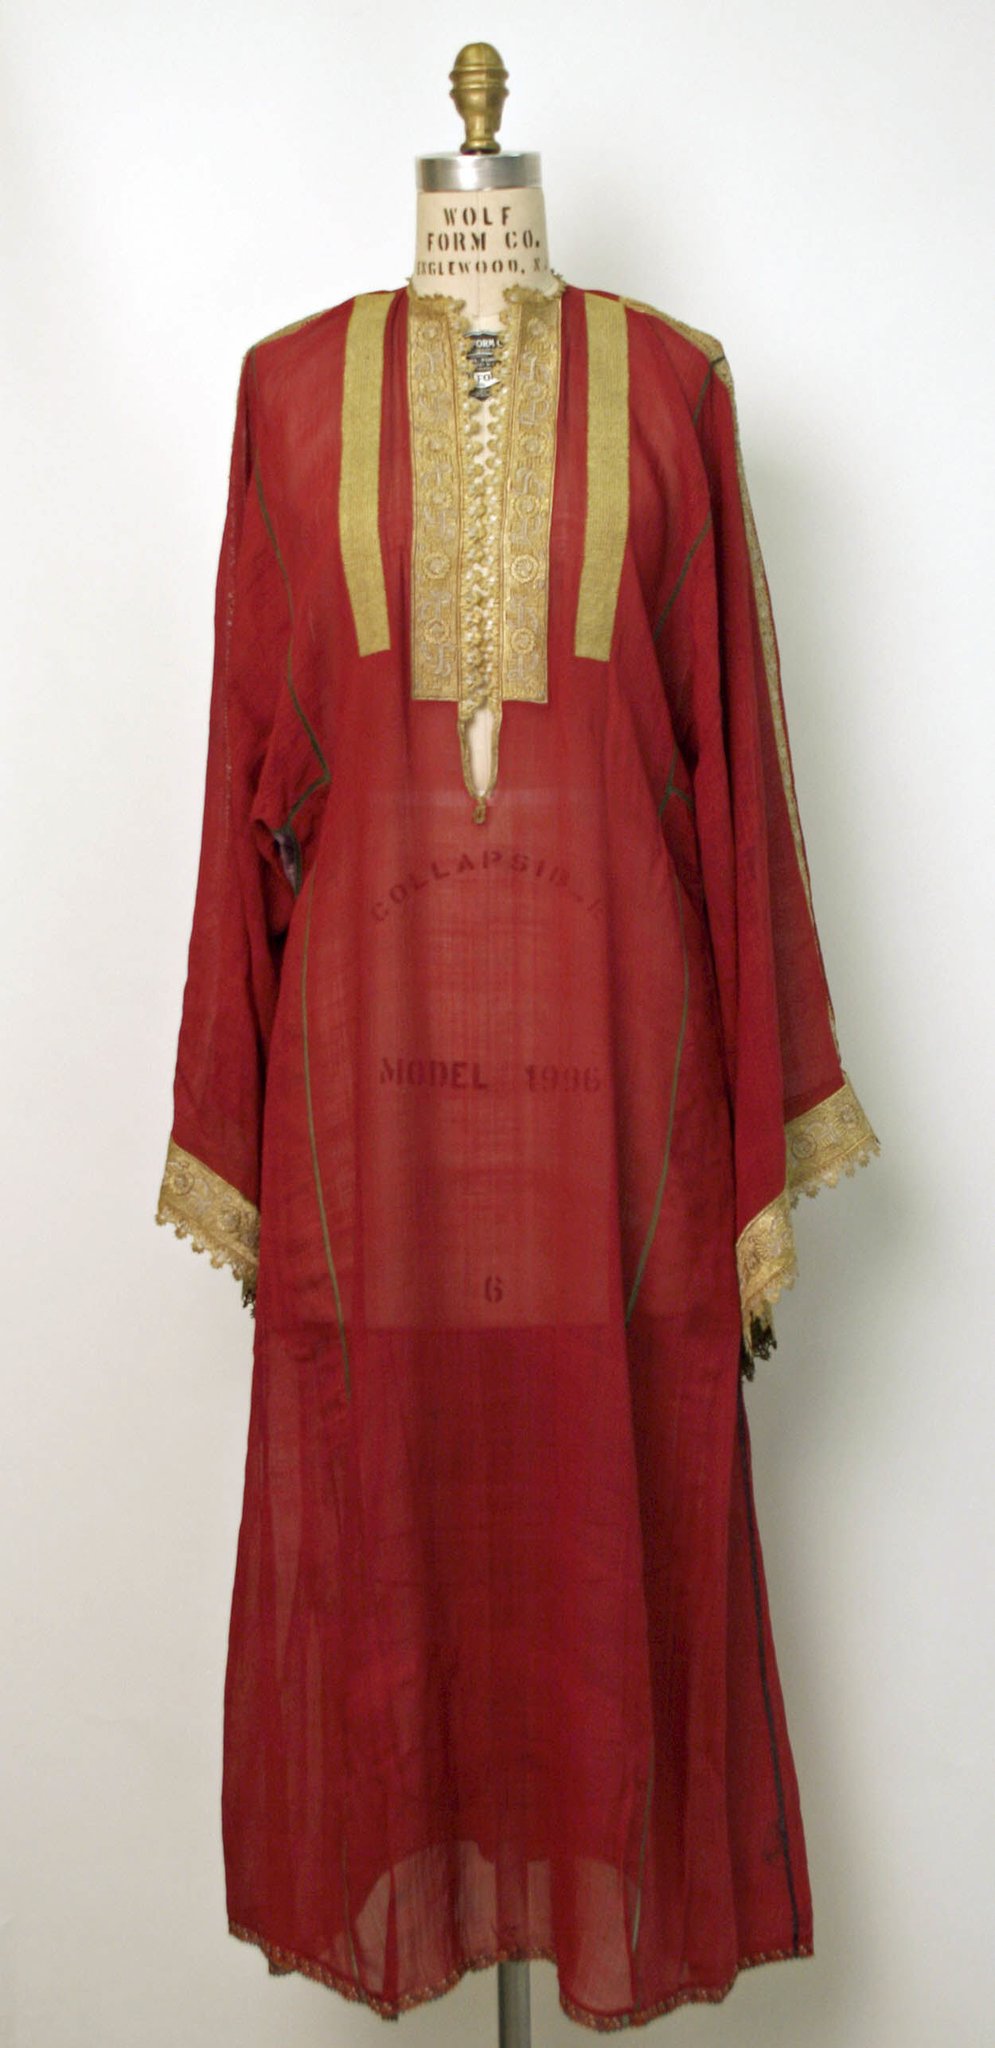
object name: underdress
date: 1801-1833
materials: metal thread, silk